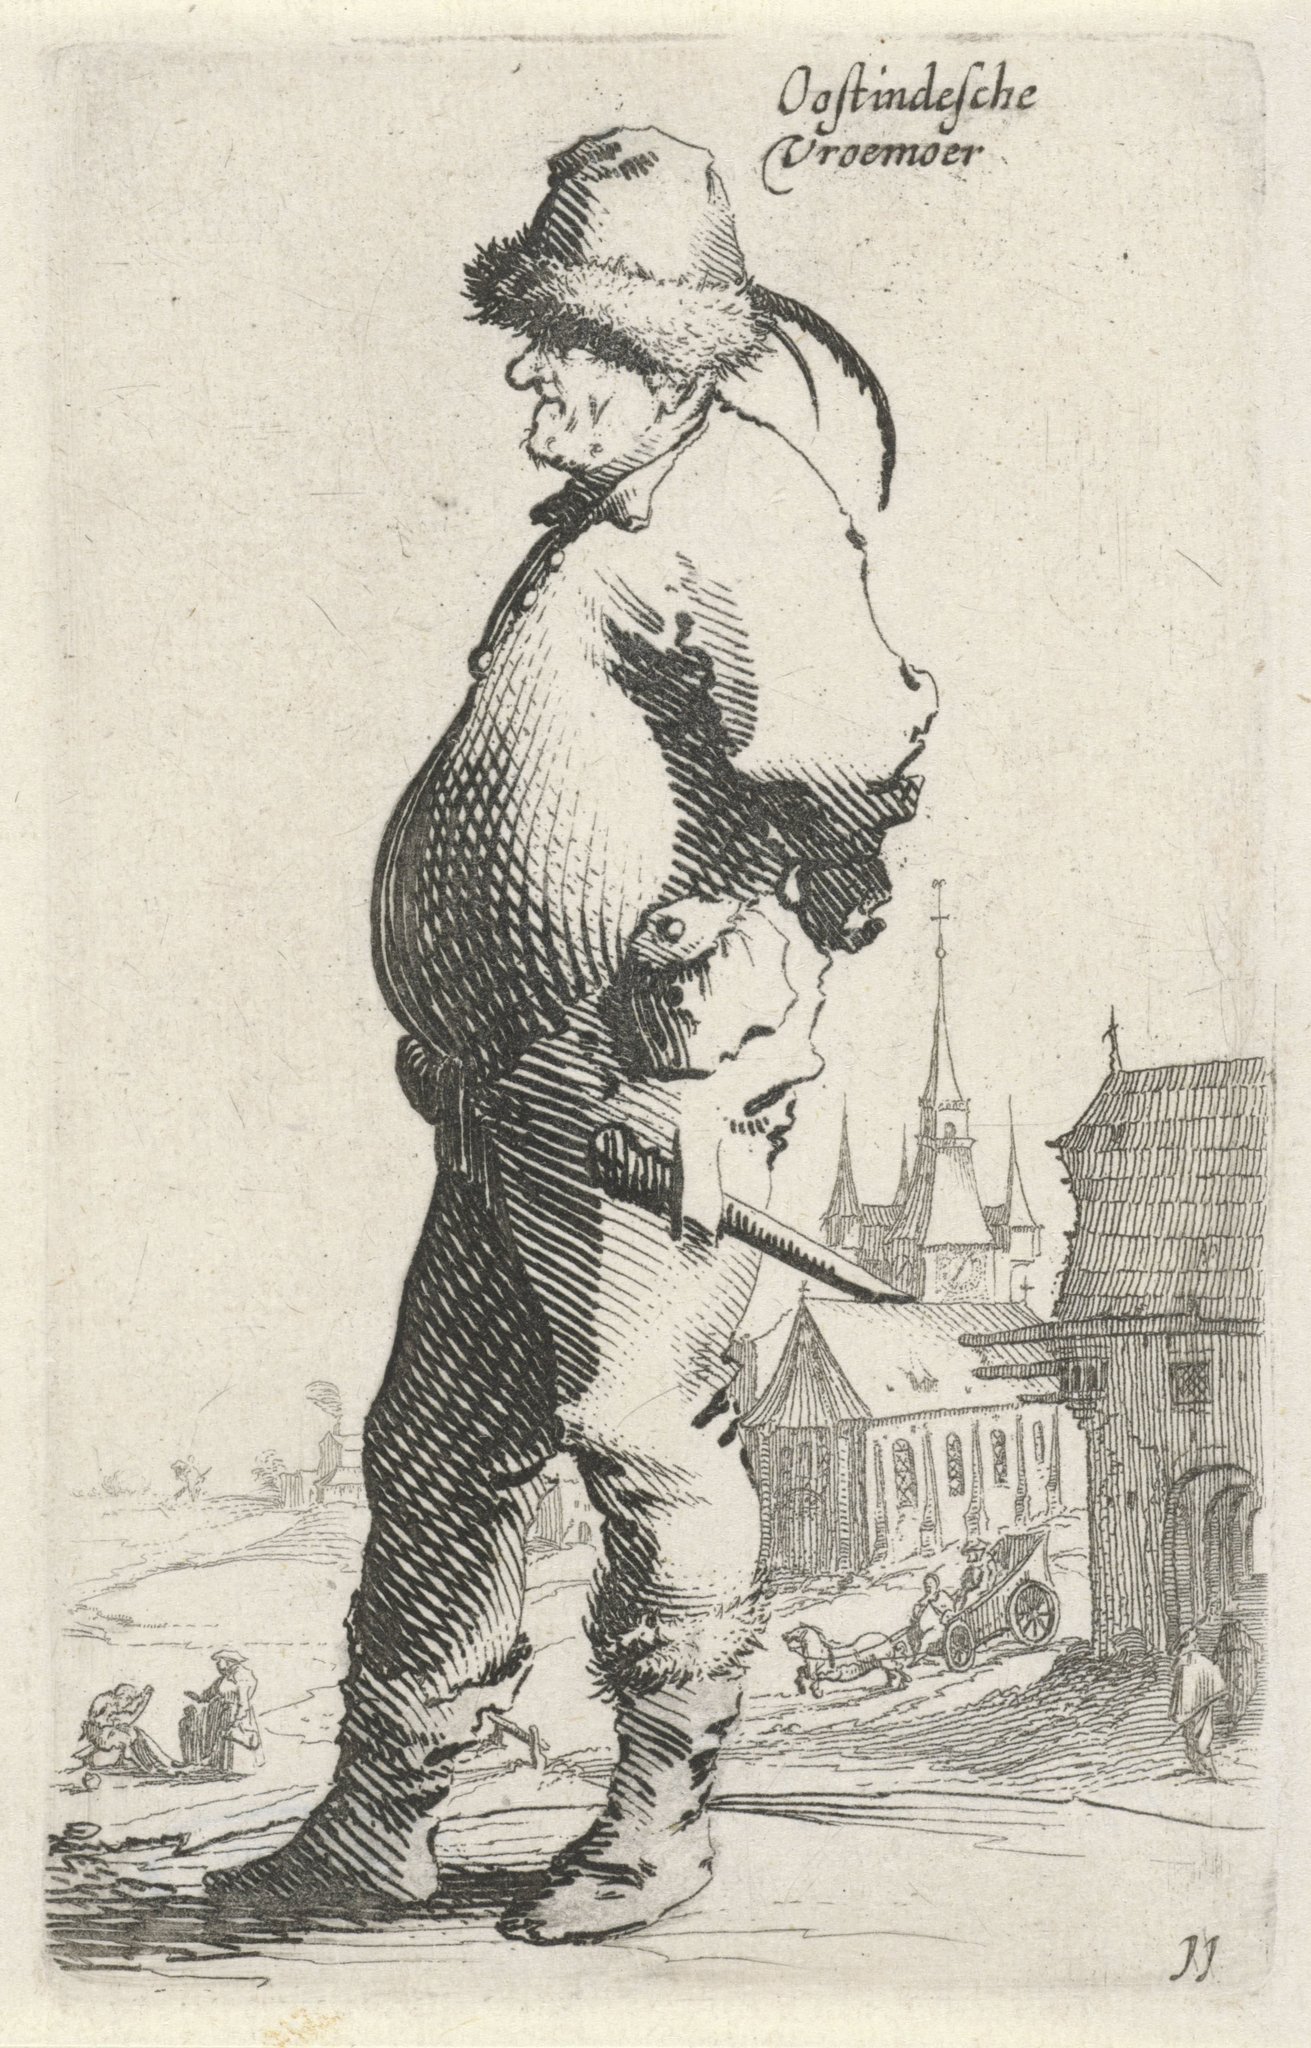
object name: print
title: Oostindesche vroemoer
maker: salomon savery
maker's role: print maker, publisher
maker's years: 1594-1683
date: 1630-1665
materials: paper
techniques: engraving, etching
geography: amsterdam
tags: farmers, church (exterior), arcade ~ architecture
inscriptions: collector's mark: Lugt 2228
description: De prent maakt deel uit van een twaalfdelige serie prenten met voorstellingen van boeren.